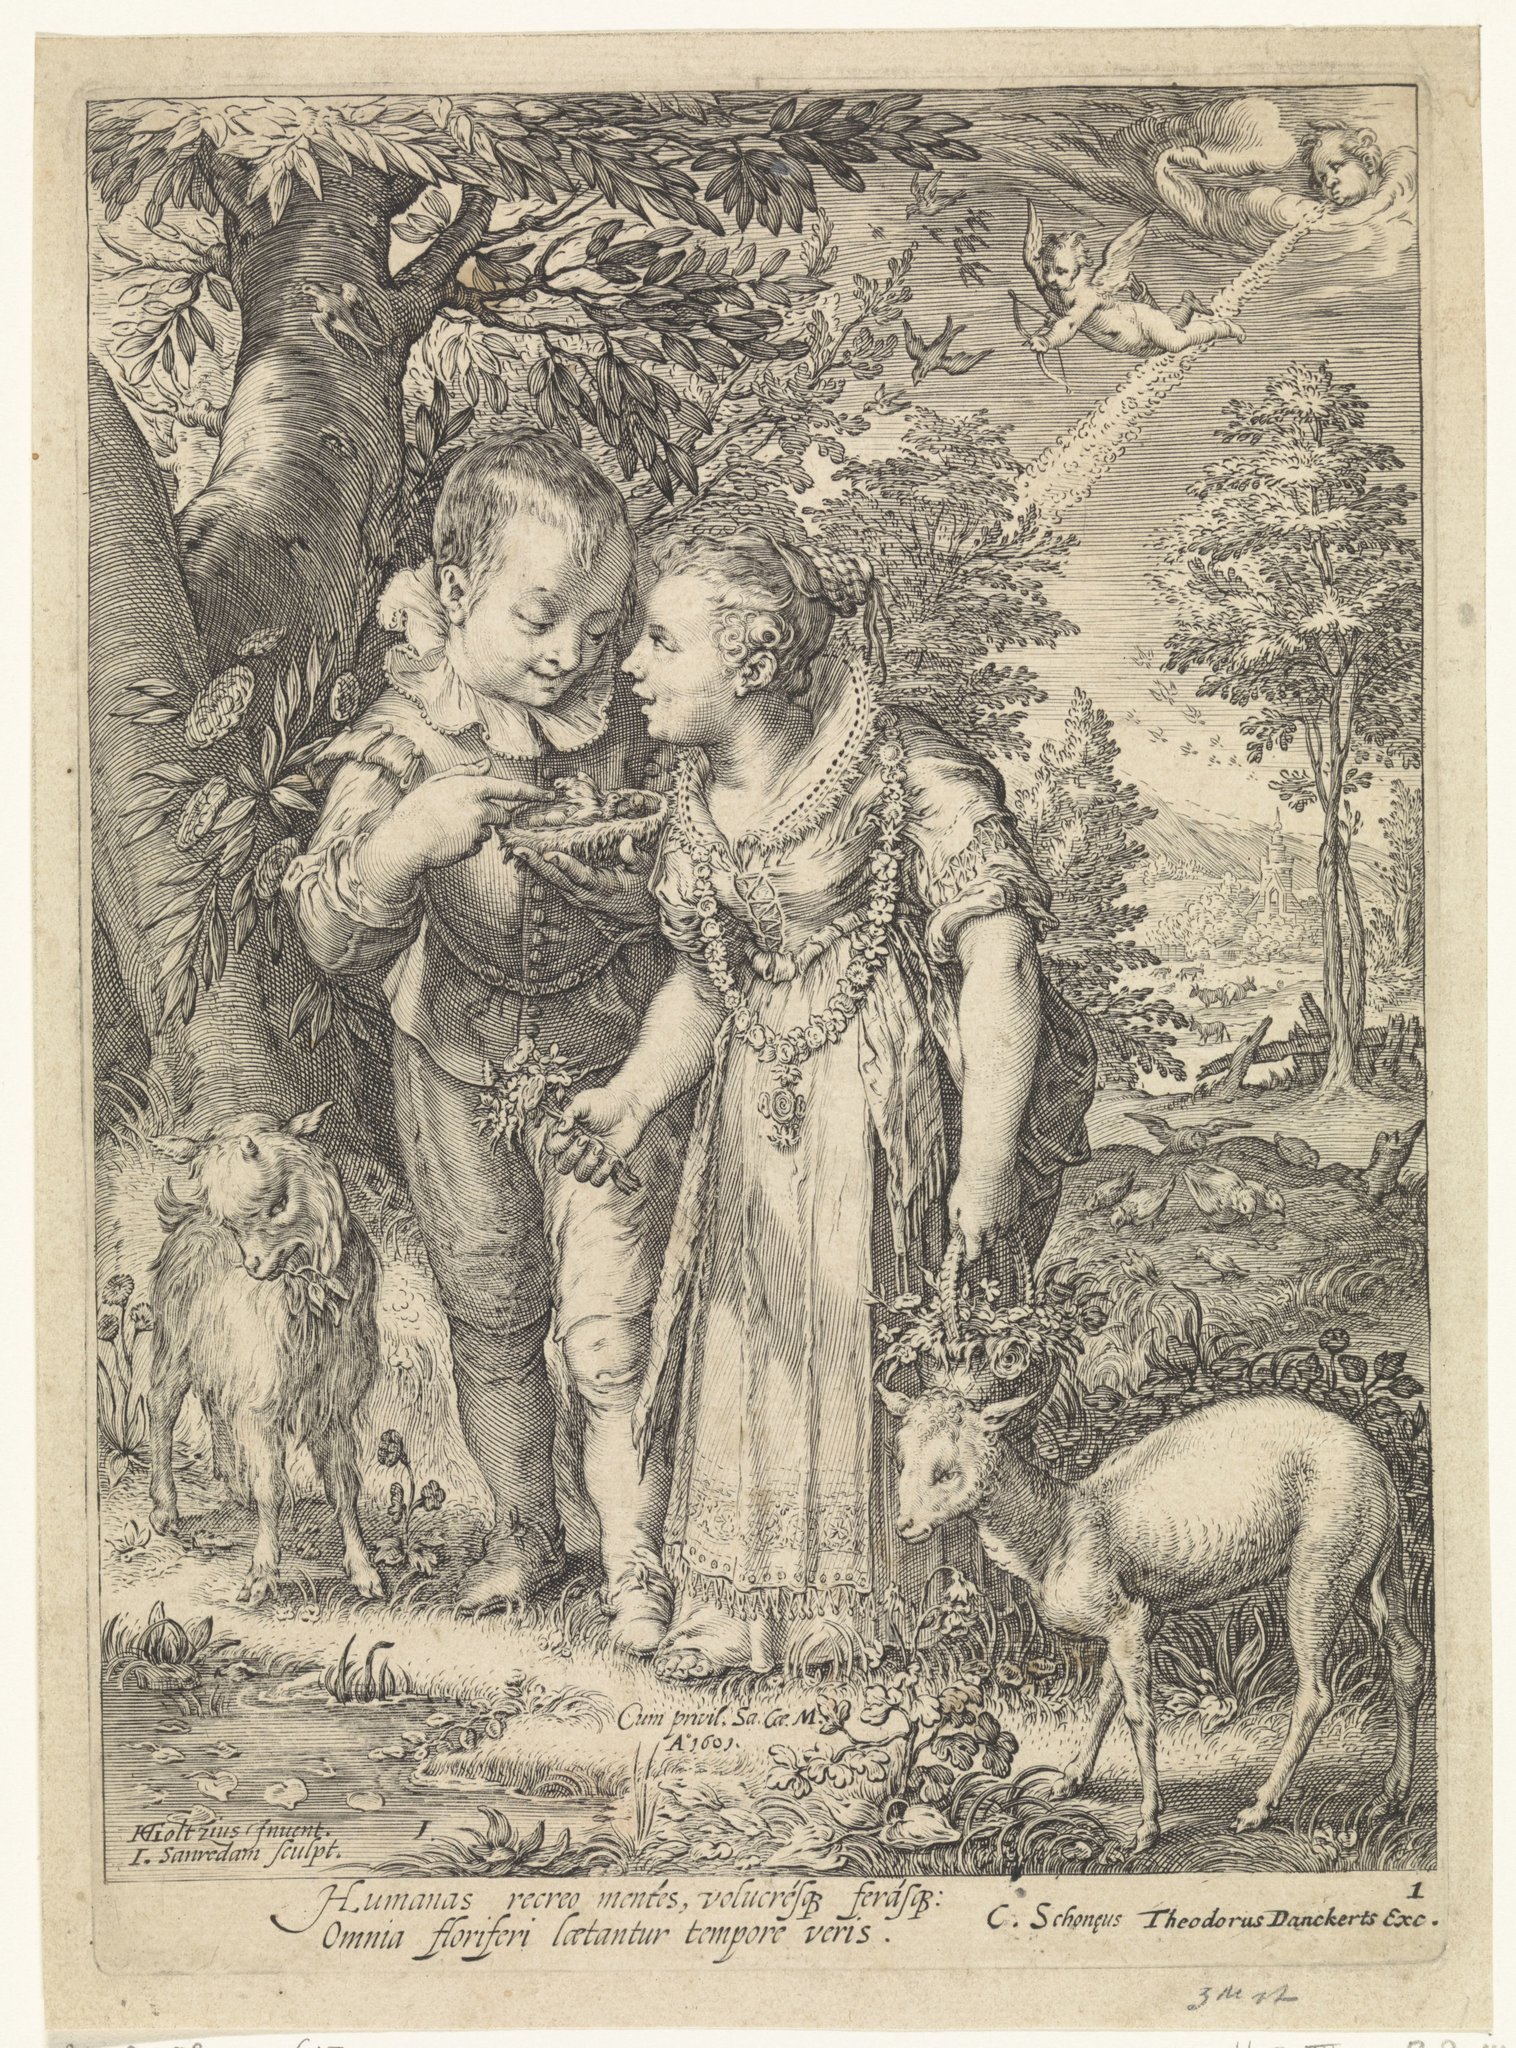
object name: print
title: De vier seizoenen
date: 1601-1702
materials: paper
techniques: engraving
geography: northern netherlands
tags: child robbing bird's nests (+ variant), spring, 'ver'; 'primavera' (ripa), spring ~ human activities (the four seasons of the year)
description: Een jongen en een meisje in een landschap. De jongen toont het meisje, met bloemenmandje in de hand, een vogelnest. Rechtsboven richt cupido zijn pijl op hen.